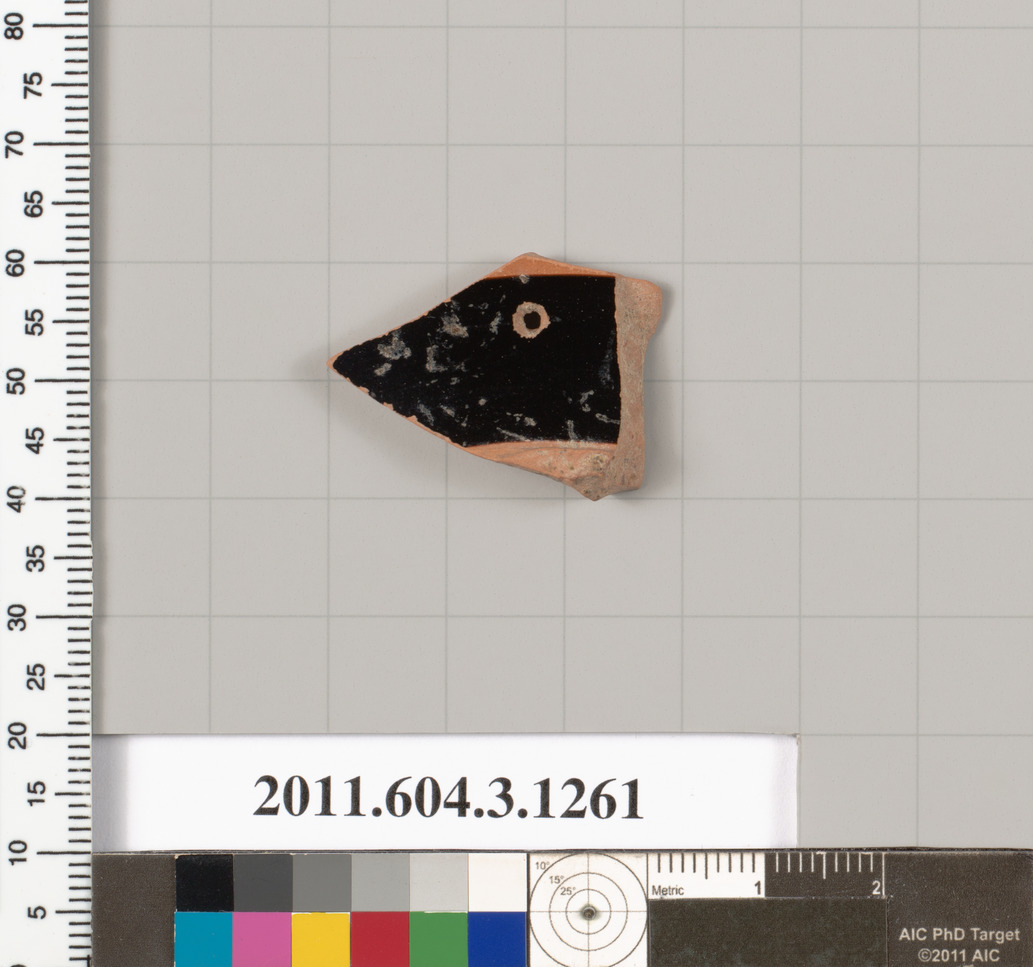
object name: undetermined shape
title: Terracotta fragment of an undetermined shape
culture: greek, attic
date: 600-401 BCE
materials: terracotta